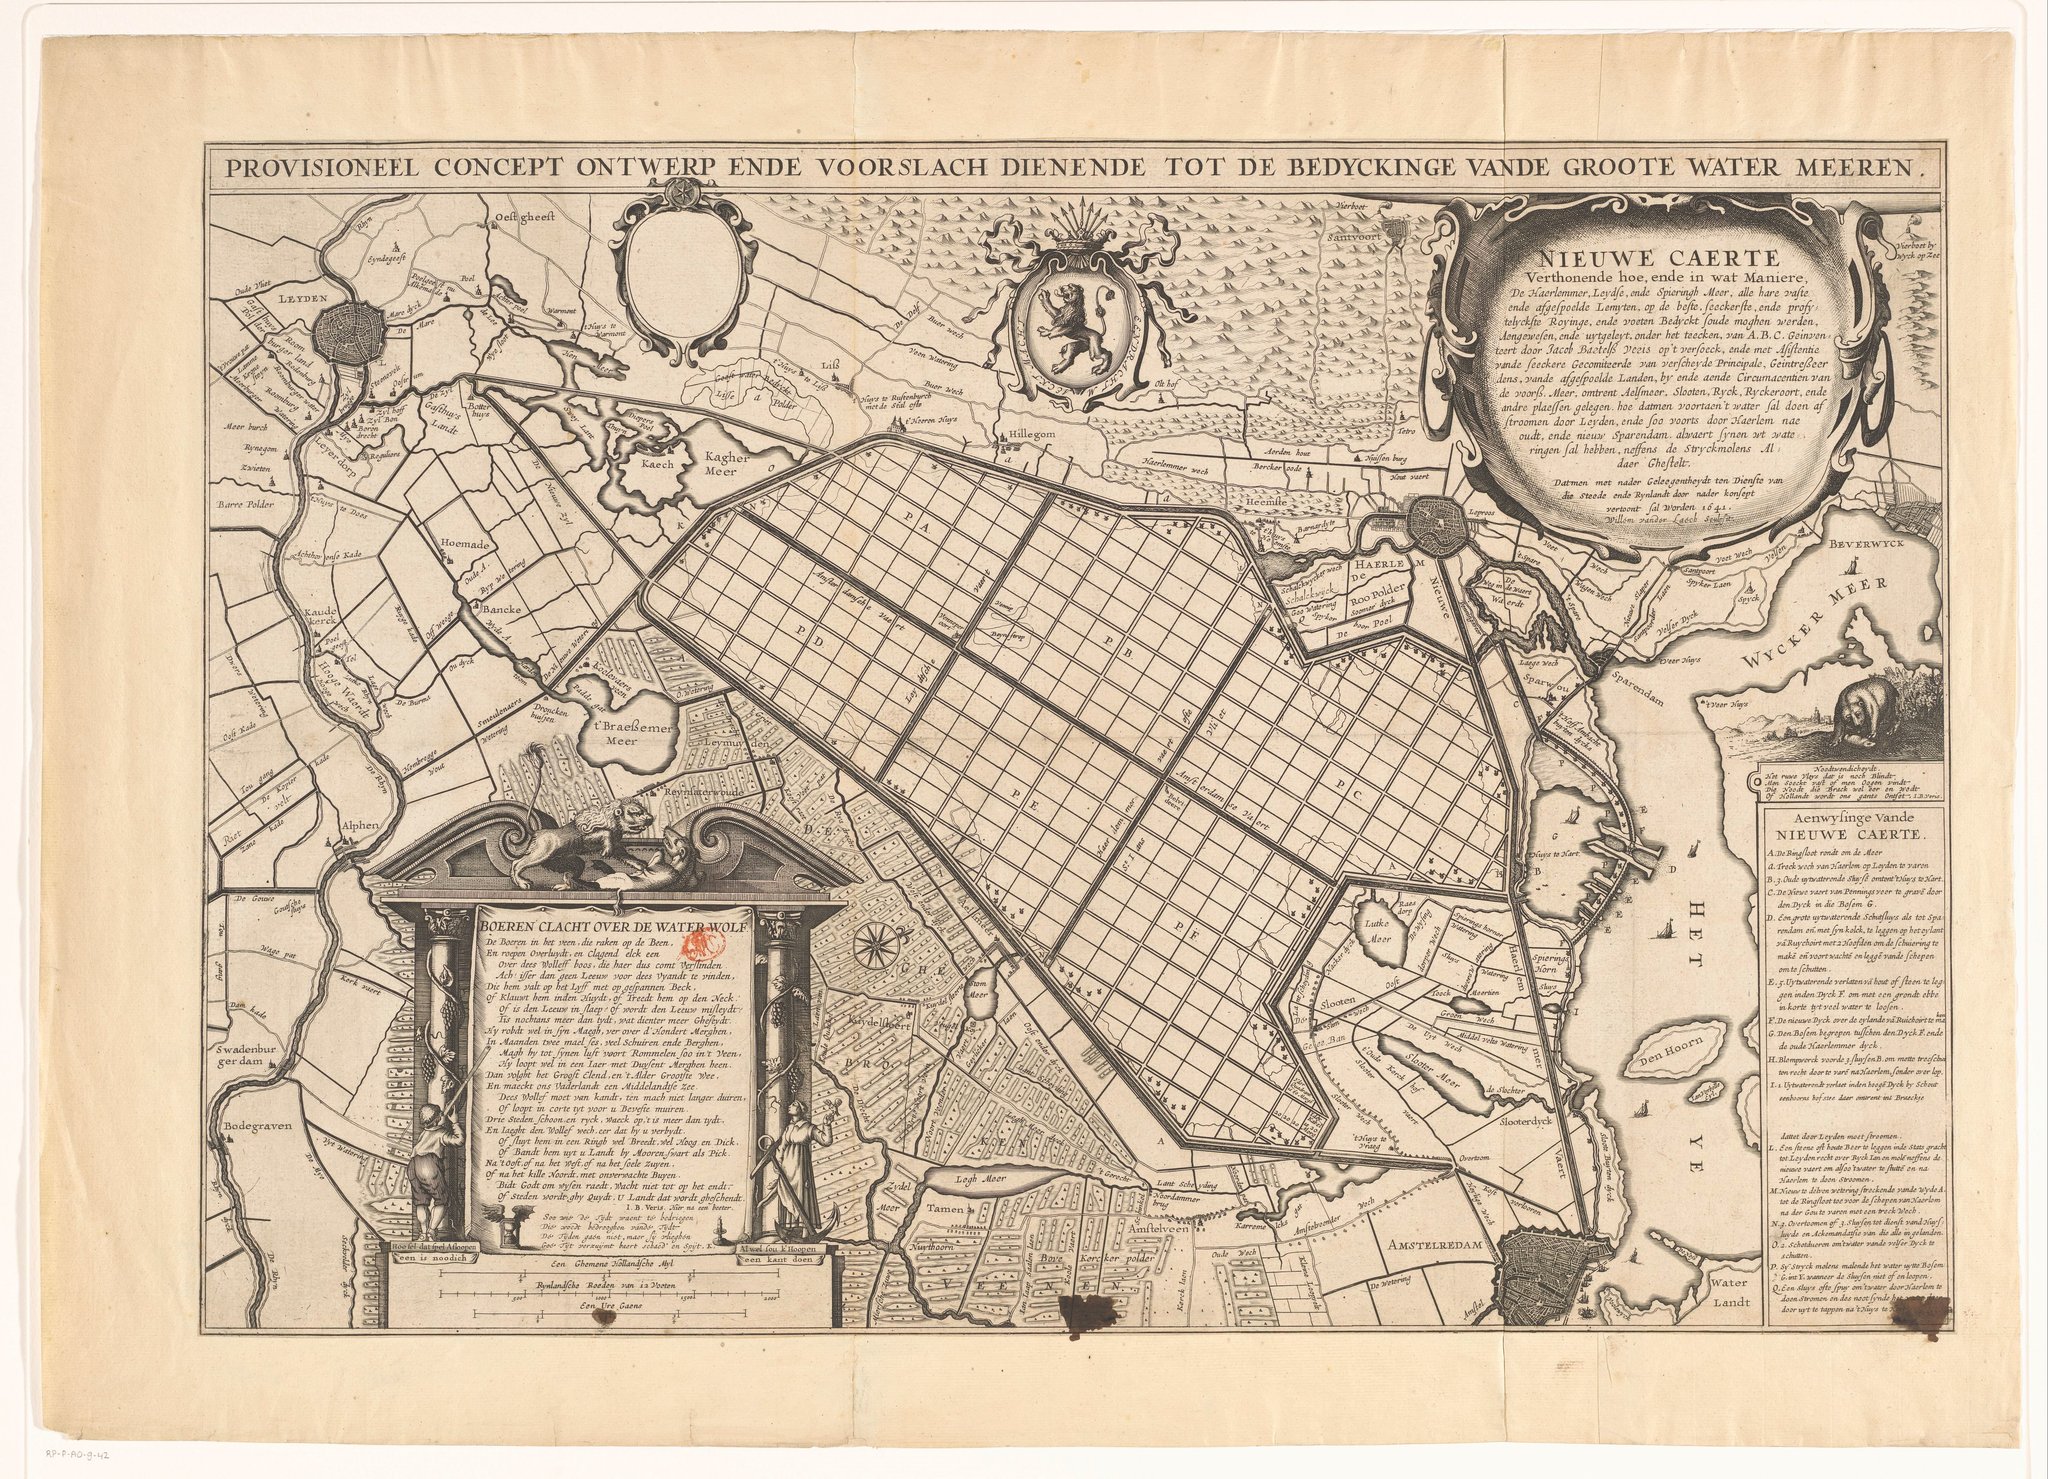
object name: map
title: Kaart met een ontwerp voor de bedijking van de Haarlemmermeer, 1641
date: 1641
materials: paper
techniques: engraving, etching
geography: northern netherlands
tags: coat of arms (as symbol of the state, etc.), maps of separate countries or regions, polder, reclaimed land, maps of cities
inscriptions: collector's mark: Lugt 2228, collector's mark: Lugt 195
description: Voor eerdere staat zie RP-P-OB-81.622. Voor soortgelijke kaarten zie RP-P-AO-9-41 en RP-P-1939-1451.